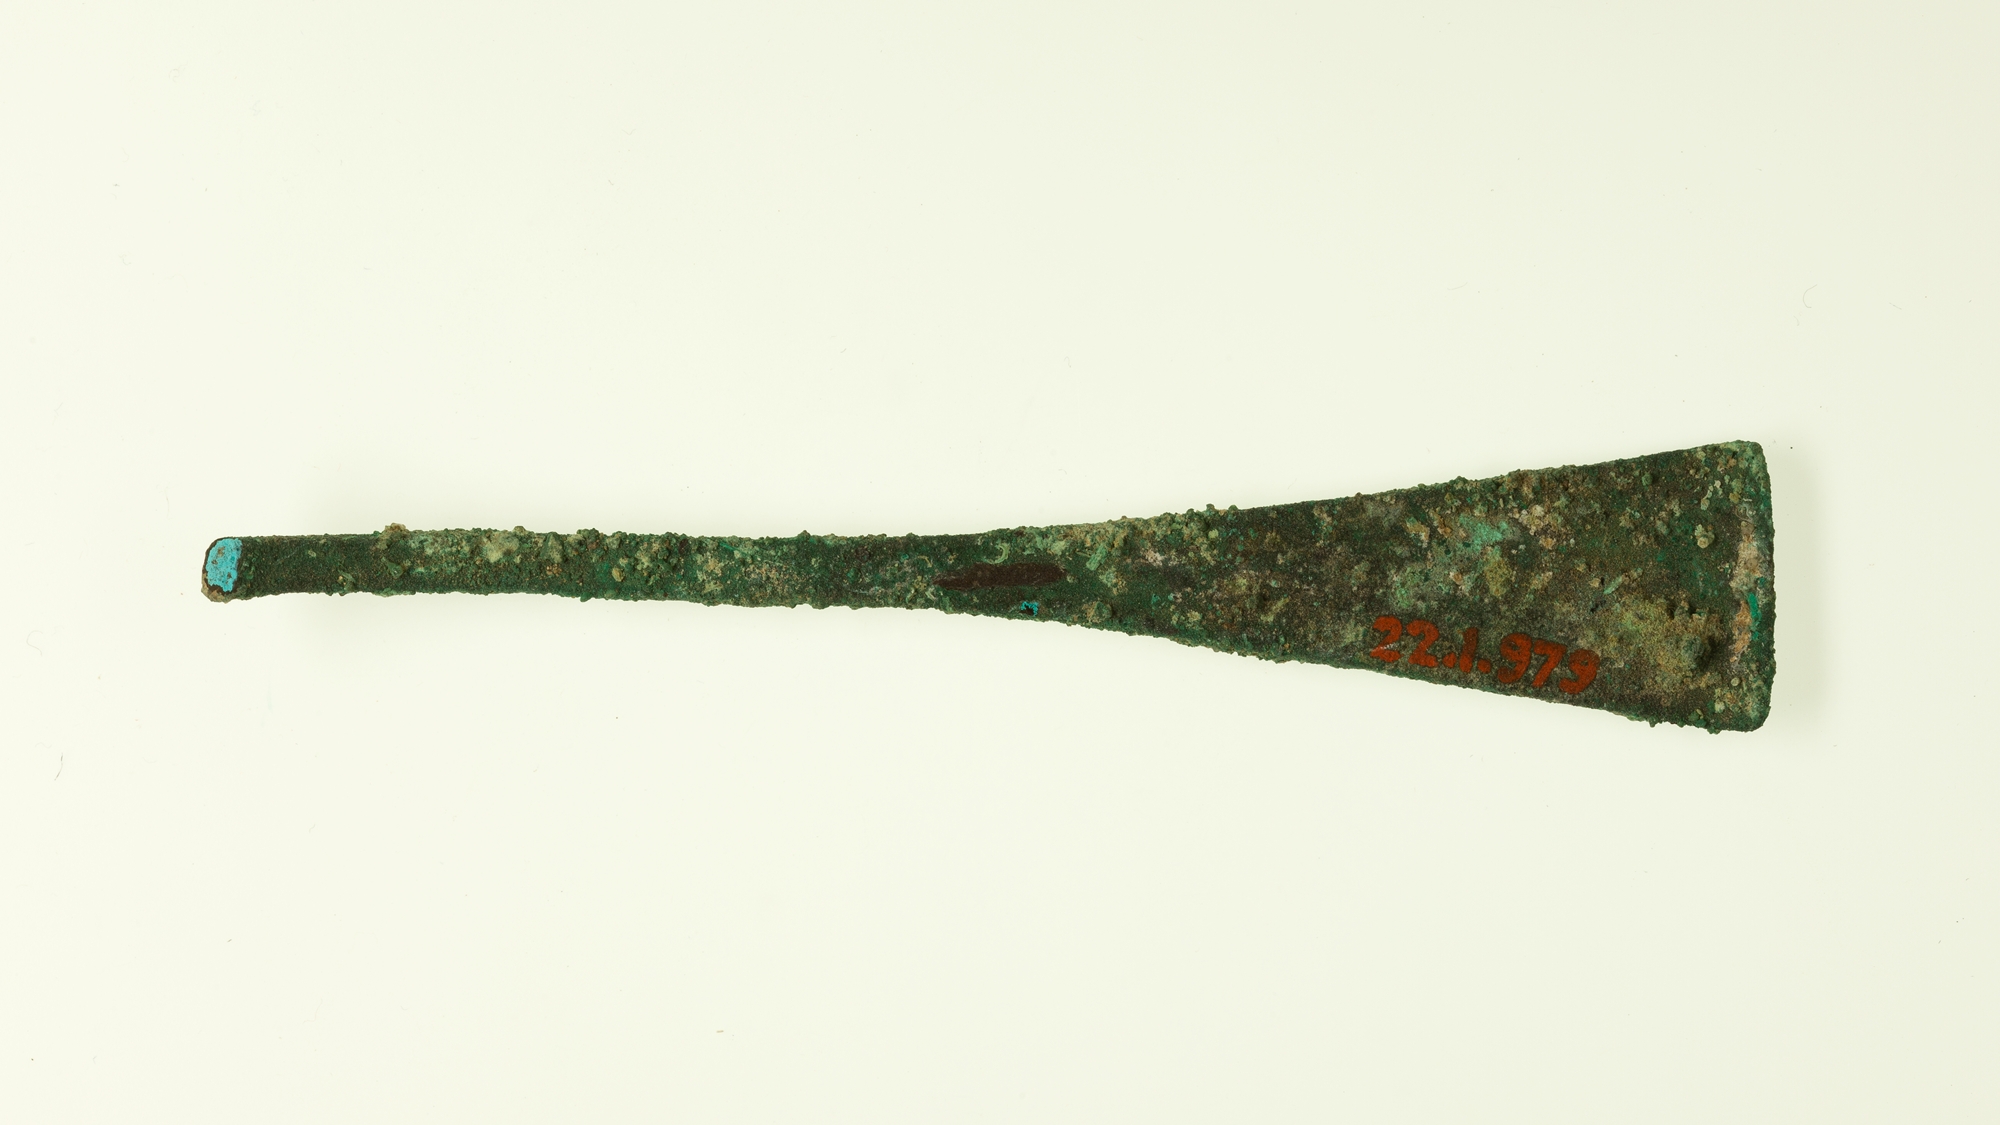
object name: tweezer fragment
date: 1295-1070 BCE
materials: bronze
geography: egypt